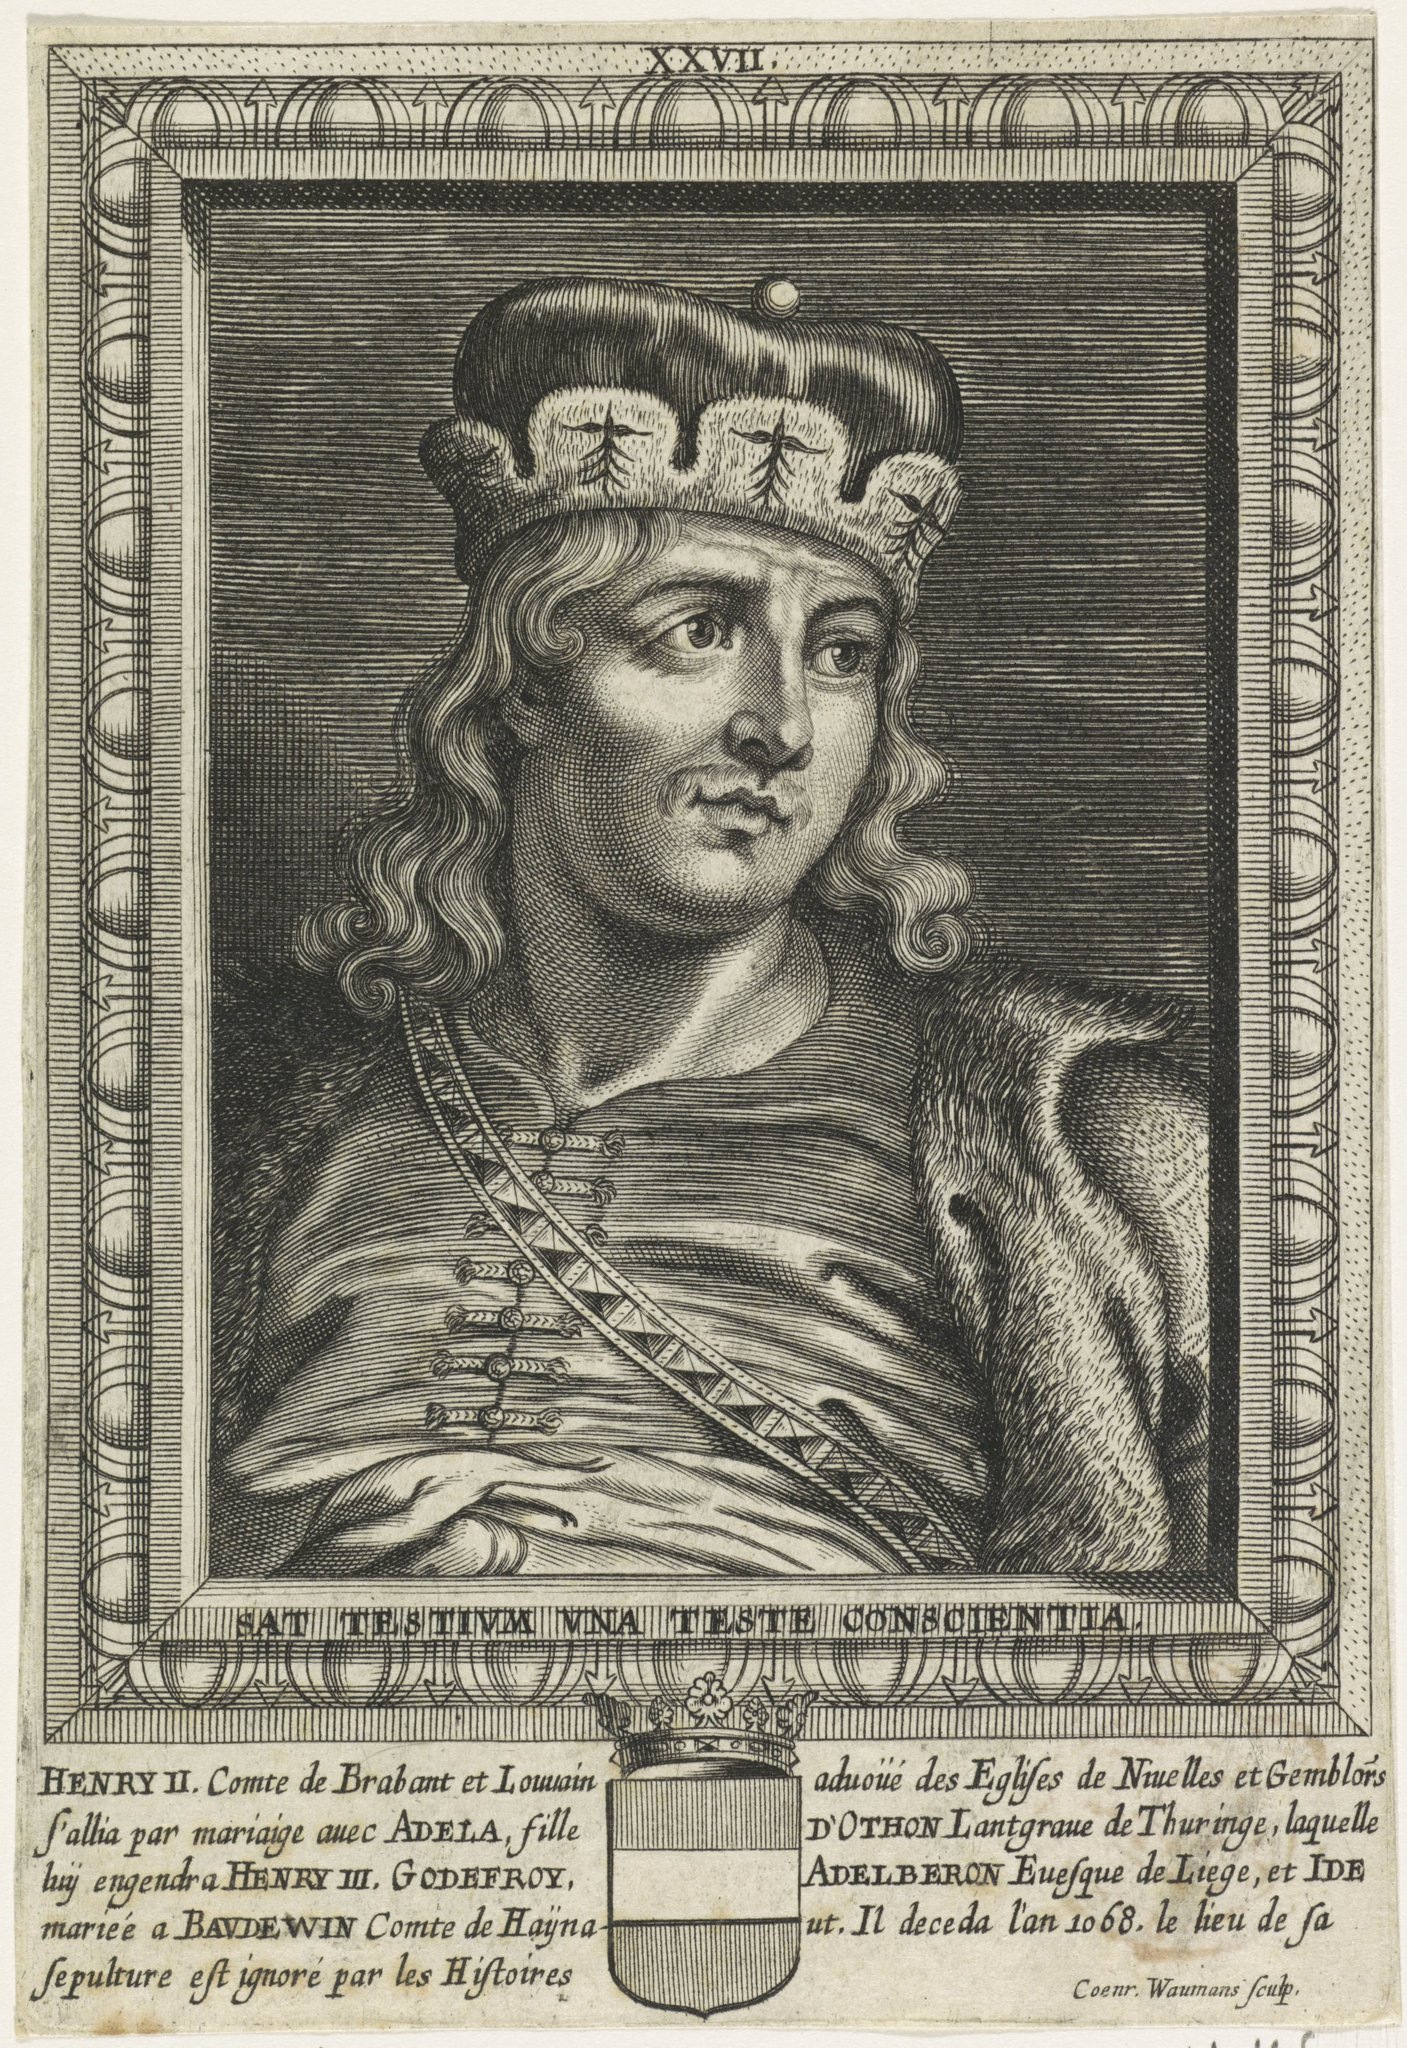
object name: print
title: Portret van Hendrik II, graaf van Brabant en Leuven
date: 1662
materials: paper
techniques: engraving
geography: antwerp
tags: earl, armorial bearing, heraldry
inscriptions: collector's mark: Lugt 240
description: Prent gebruikt in: Meyssens, C. Les pourtraits des souverains princes et comtes de Hollande. Antwerpen: J. Meyssens, 1662. Op de frontispiece wordt Richard Collin specifiek genoemd als graveur van de wapenschilden op de prenten in deze uitgave.